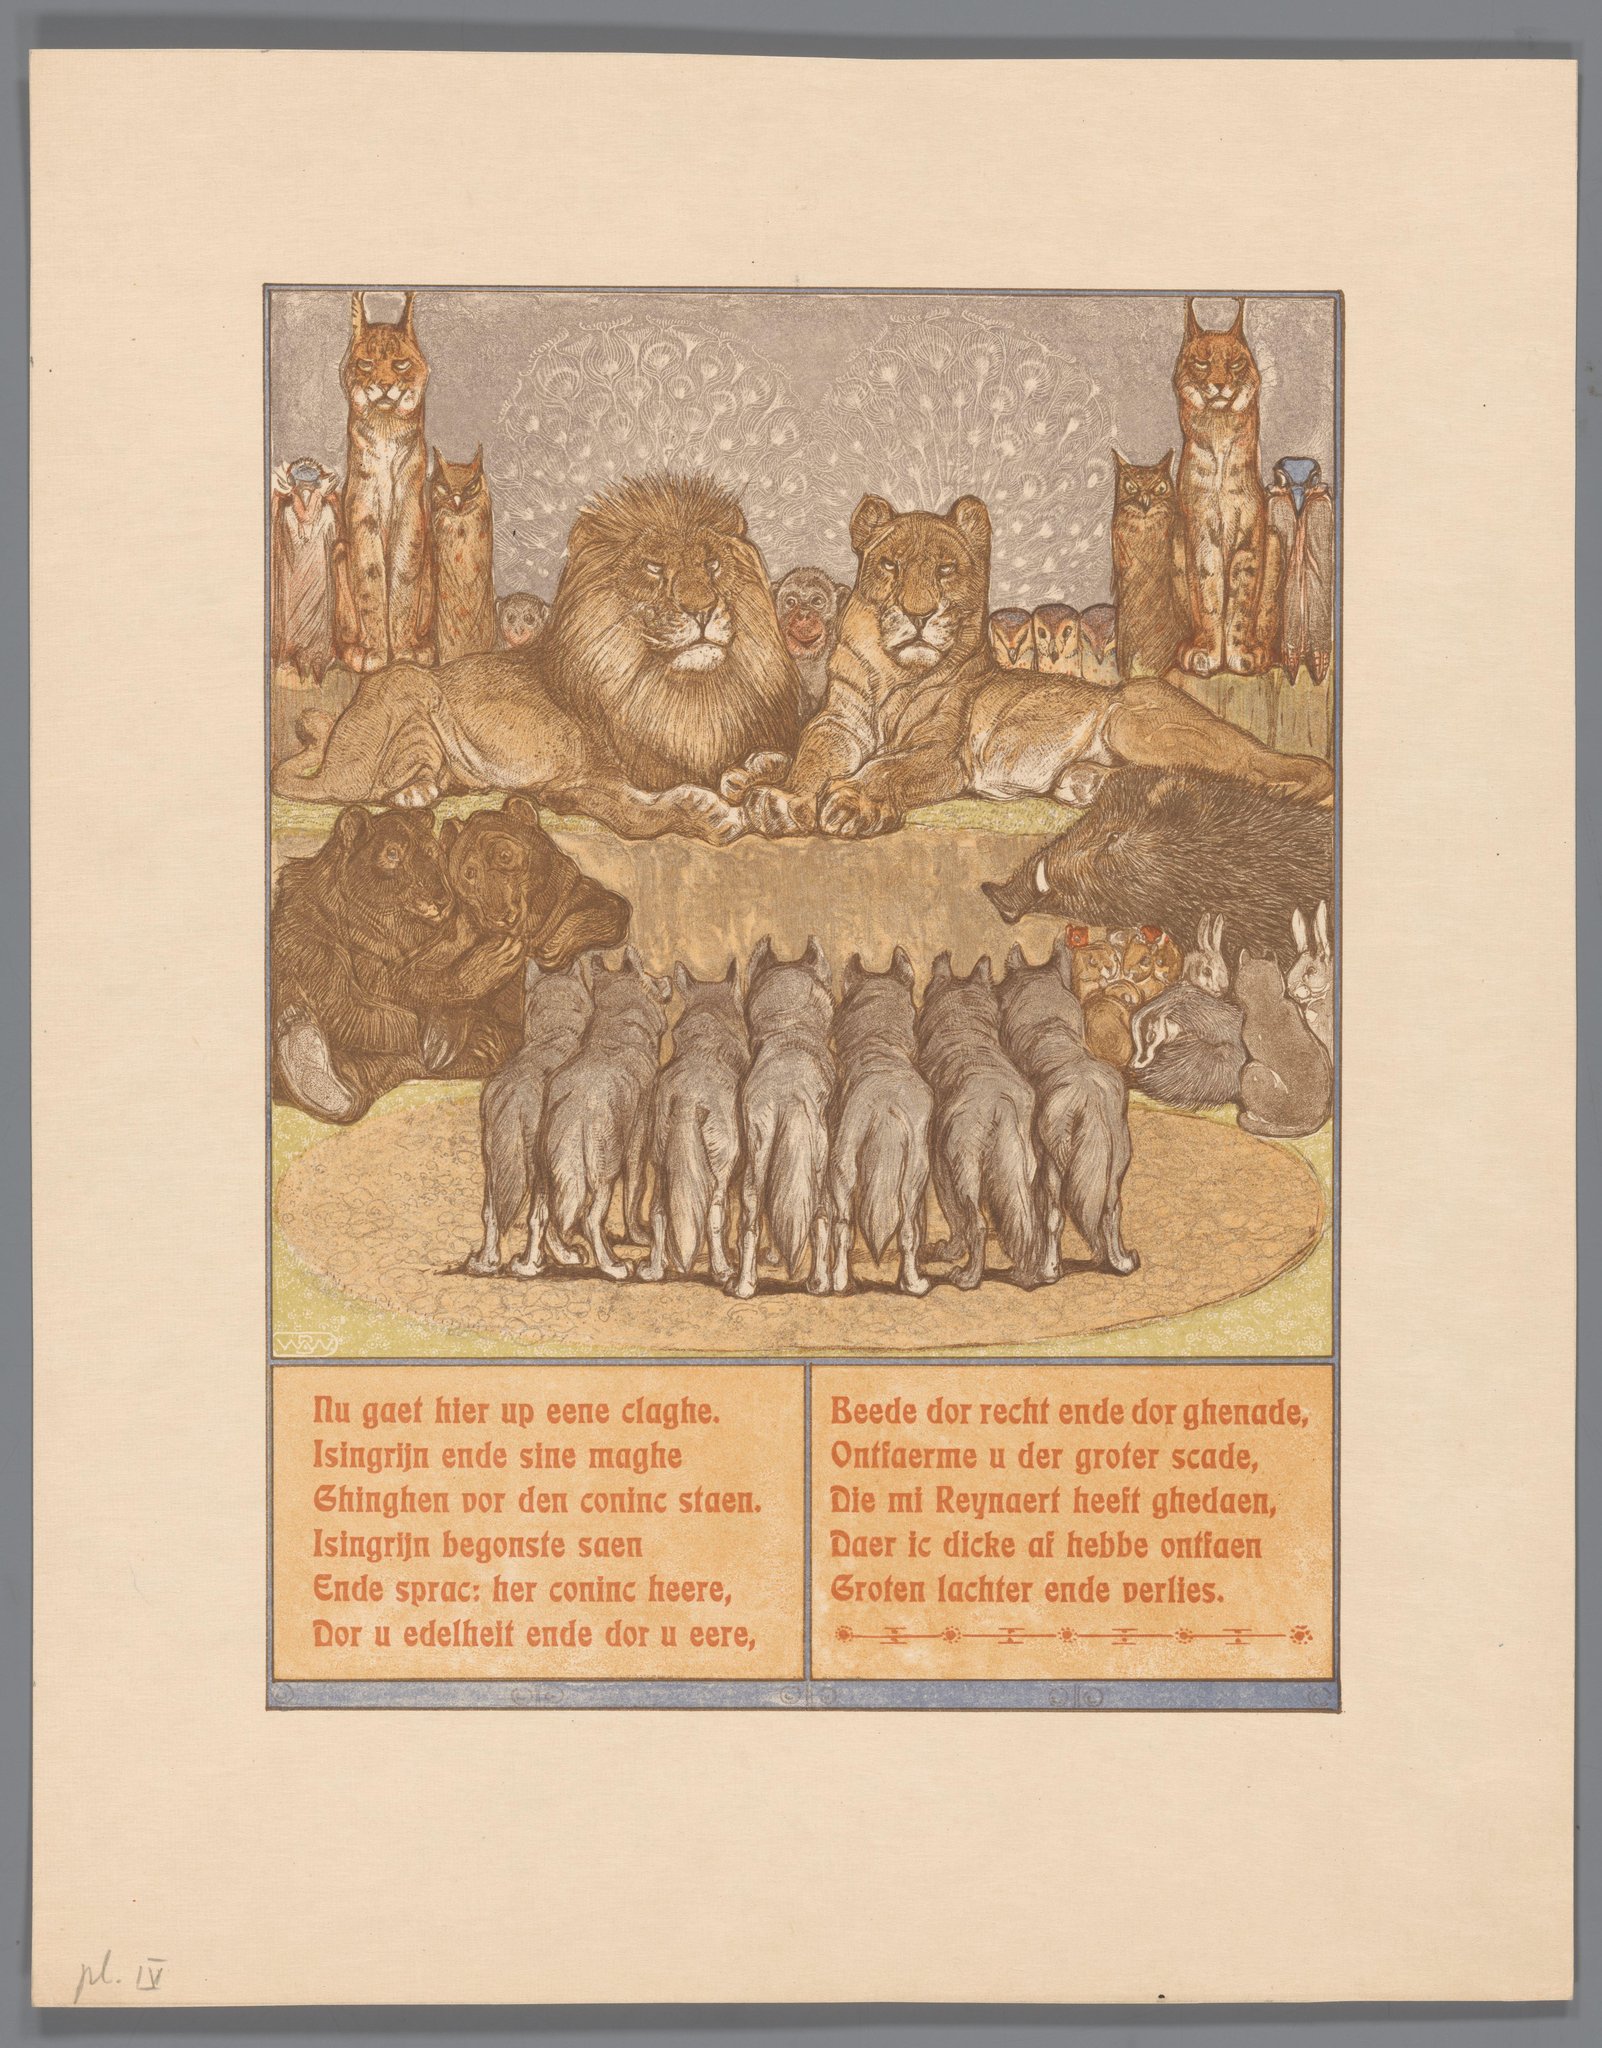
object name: book illustration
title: Groep wolven voor een liggende leeuw (Nobel) en leeuwin (Gentel)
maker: bernard willem wierink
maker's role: draughtsman, print maker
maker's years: 1856-1939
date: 1910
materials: paper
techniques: lithograph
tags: fable of reynard the fox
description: Prent gebruikt in: Streuvels, Stijn (Frank Lateur). Reinaert de Vos naar verschillende uitgaven van het middeleeuwsche epos. Amsterdam: L.J. Veen, 1910.